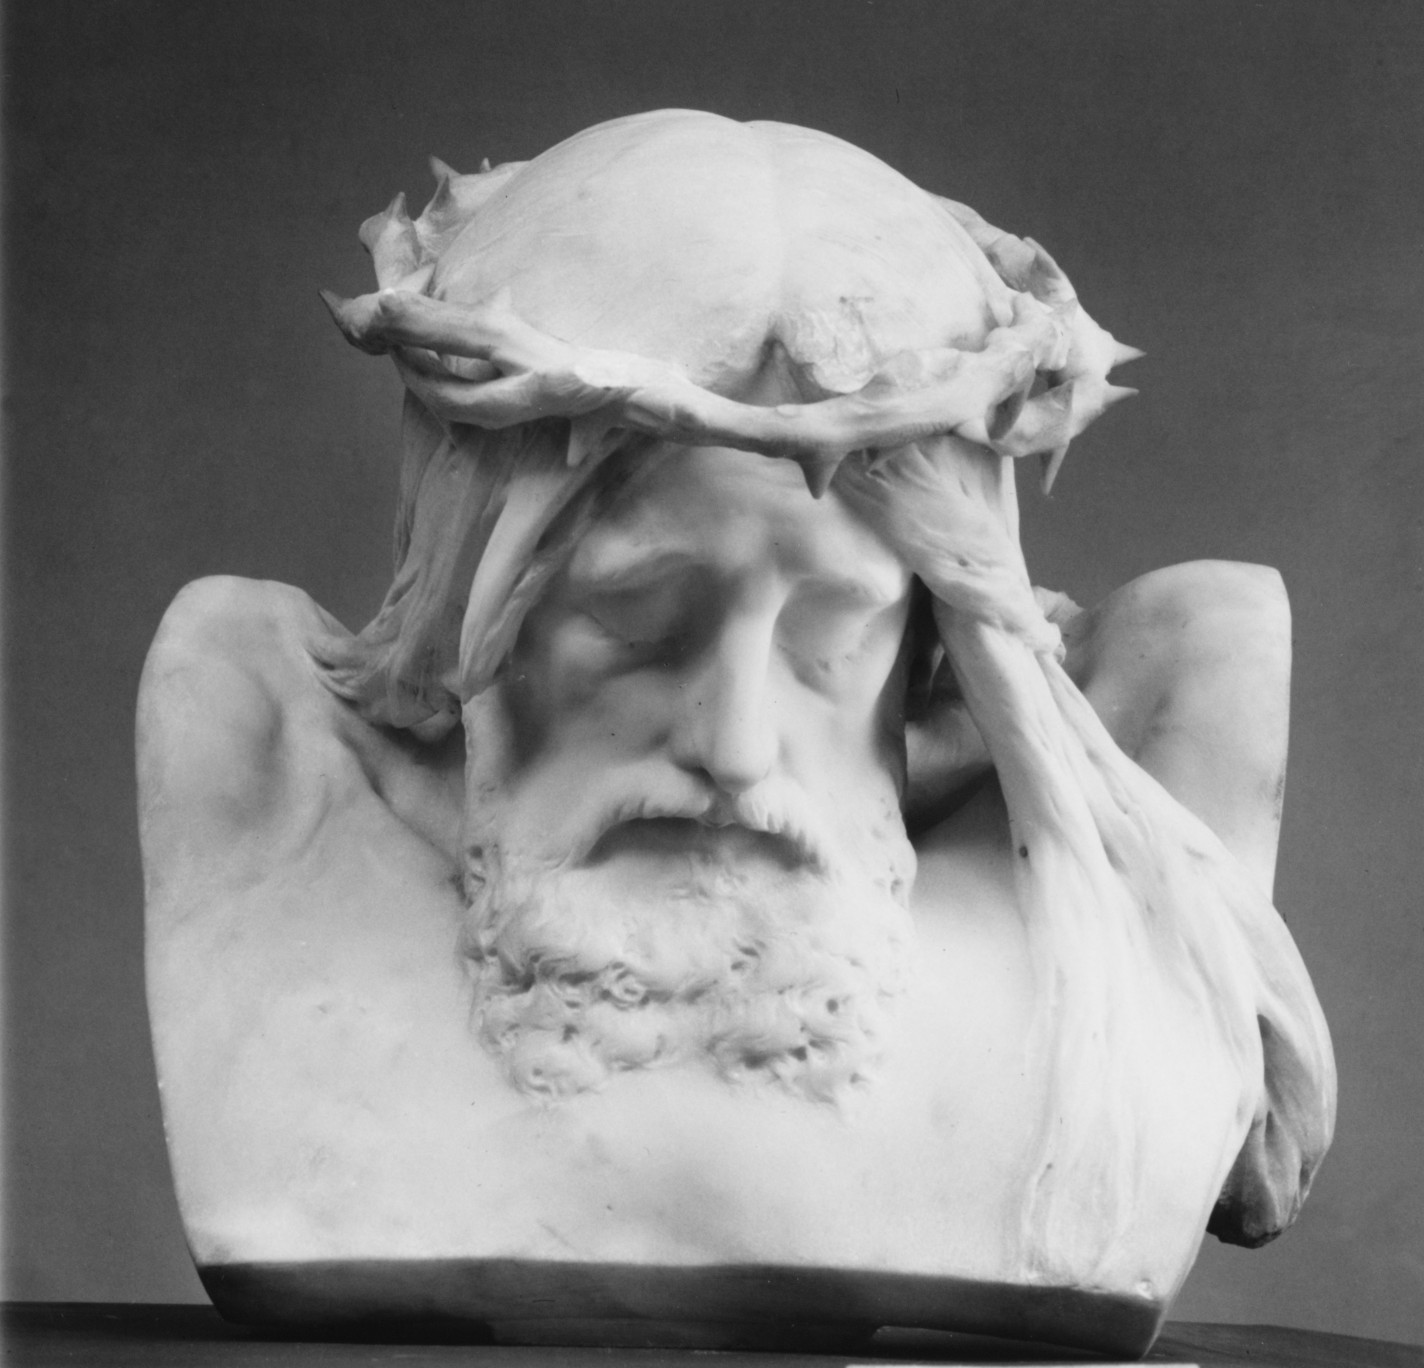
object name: bust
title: It is Finished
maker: lord ronald sutherland gower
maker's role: artist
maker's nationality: british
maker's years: 1845-1916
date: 1875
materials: marble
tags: jesus